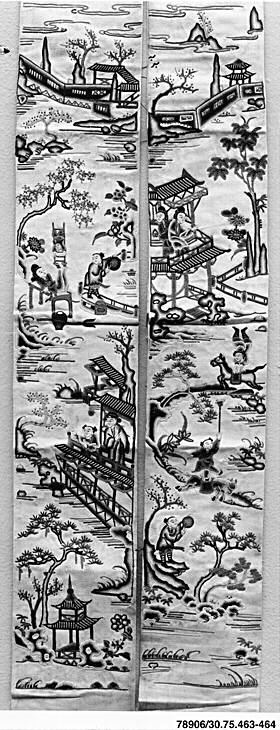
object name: sleeve band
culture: chinese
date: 1801-1900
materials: silk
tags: human figures